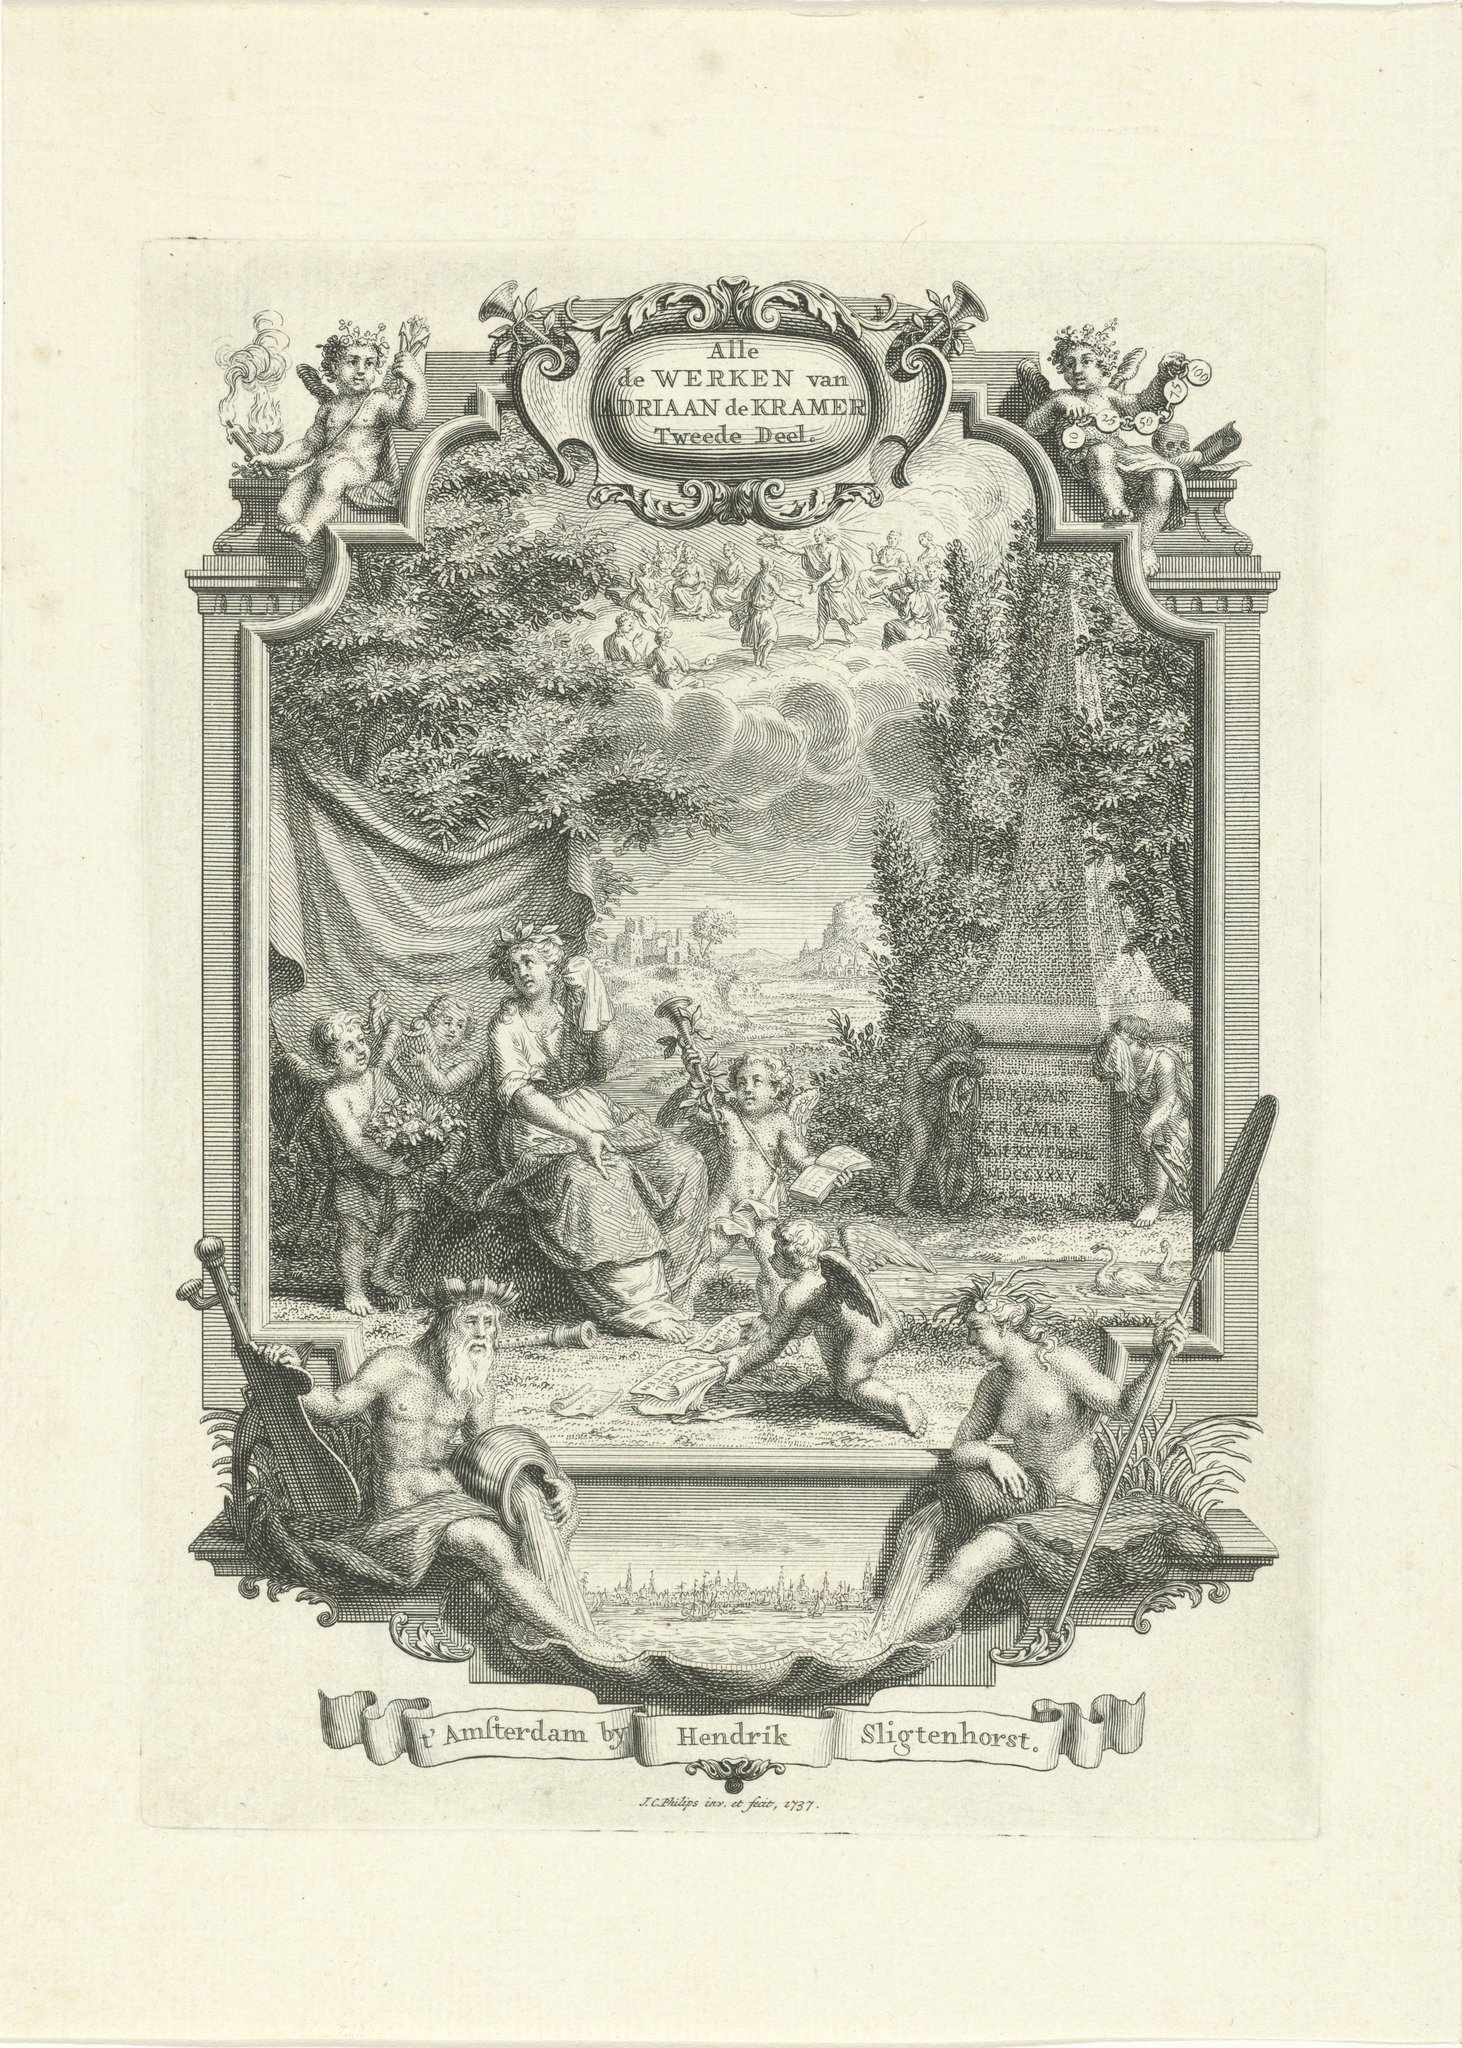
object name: print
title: Titelpagina voor: J.A. van Orsoĳ, Alle de werken van Adriaan de Kramer, 1737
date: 1737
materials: paper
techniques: engraving, etching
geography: amsterdam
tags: river-gods, symbolic representations, allegories and emblems ~ poetry; 'poesia' (ripa), the muses acting together (as group), crowning with laurel, grave, tomb and other grave-forms and grave-markers, amsterdam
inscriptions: collector's mark: Lugt 2233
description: Poëzie treurt om de dood van de schrijver Adriaan de Kramer. Ze wordt vergezeld door putti met attributen die de kunsten symboliseren. Op de achtergrond het grafmonument met het portret van de schrijver. In de hemel wordt hij gelauwerd, omringd door muzen. In de omlijsting van de cartouche een gezicht op Amsterdam, geflankeerd door twee riviergoden. Op de bovenhoeken putti met Vanitas symbolen.